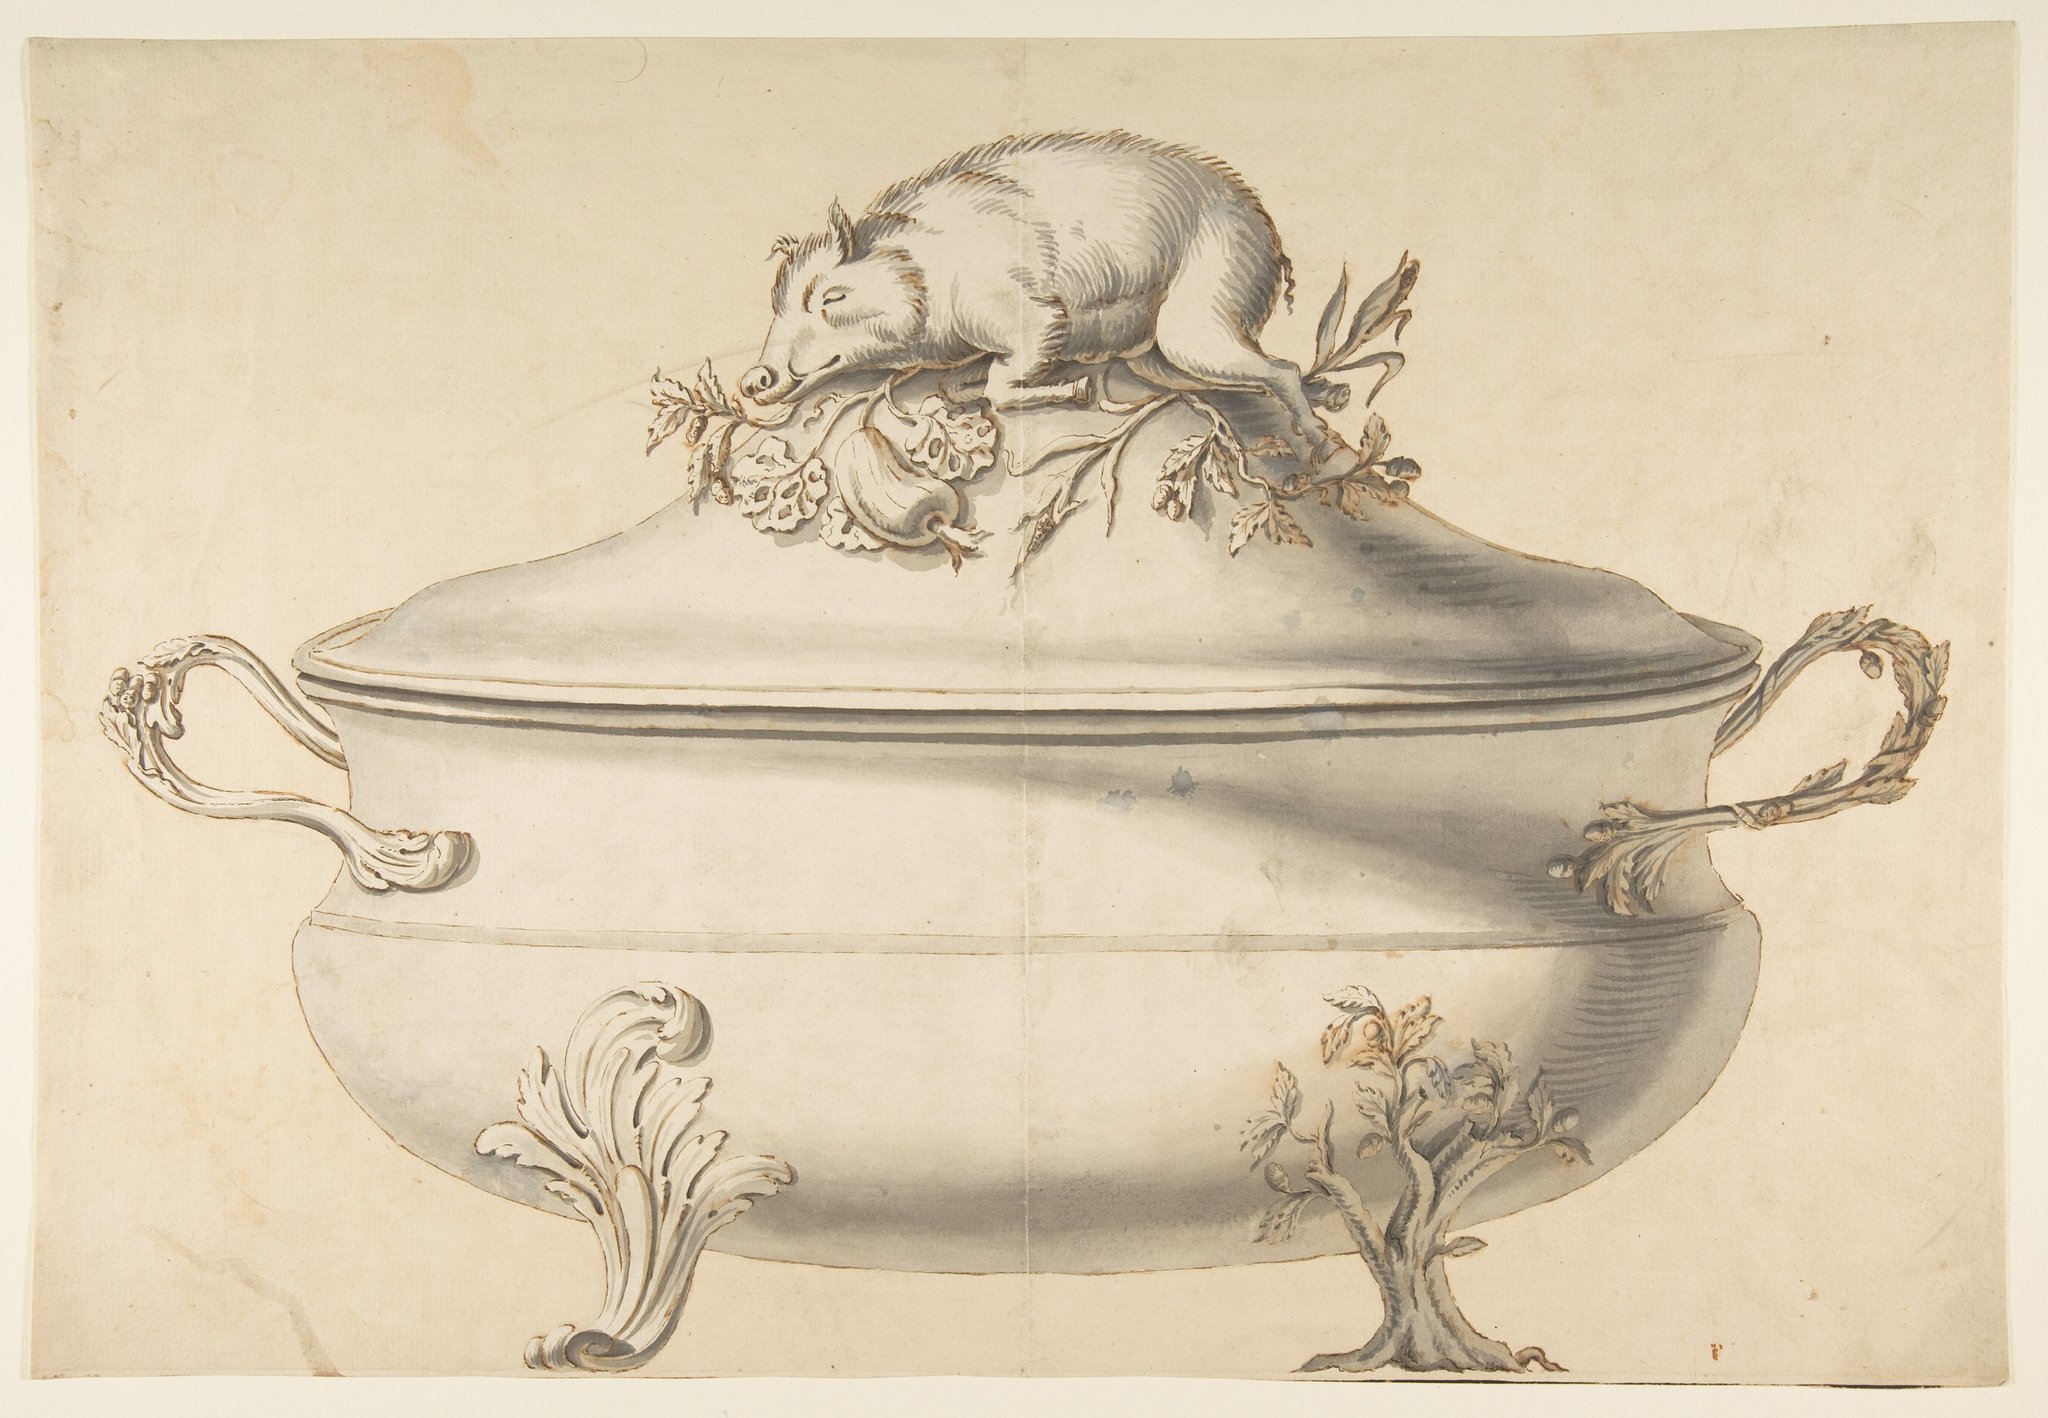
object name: drawing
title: Design for a Soup Tureen with Pig on Top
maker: anonymous, french, 19th century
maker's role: artist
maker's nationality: french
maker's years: 1800-1900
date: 1801-1900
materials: ink, paper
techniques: pen, wash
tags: pigs,tureens